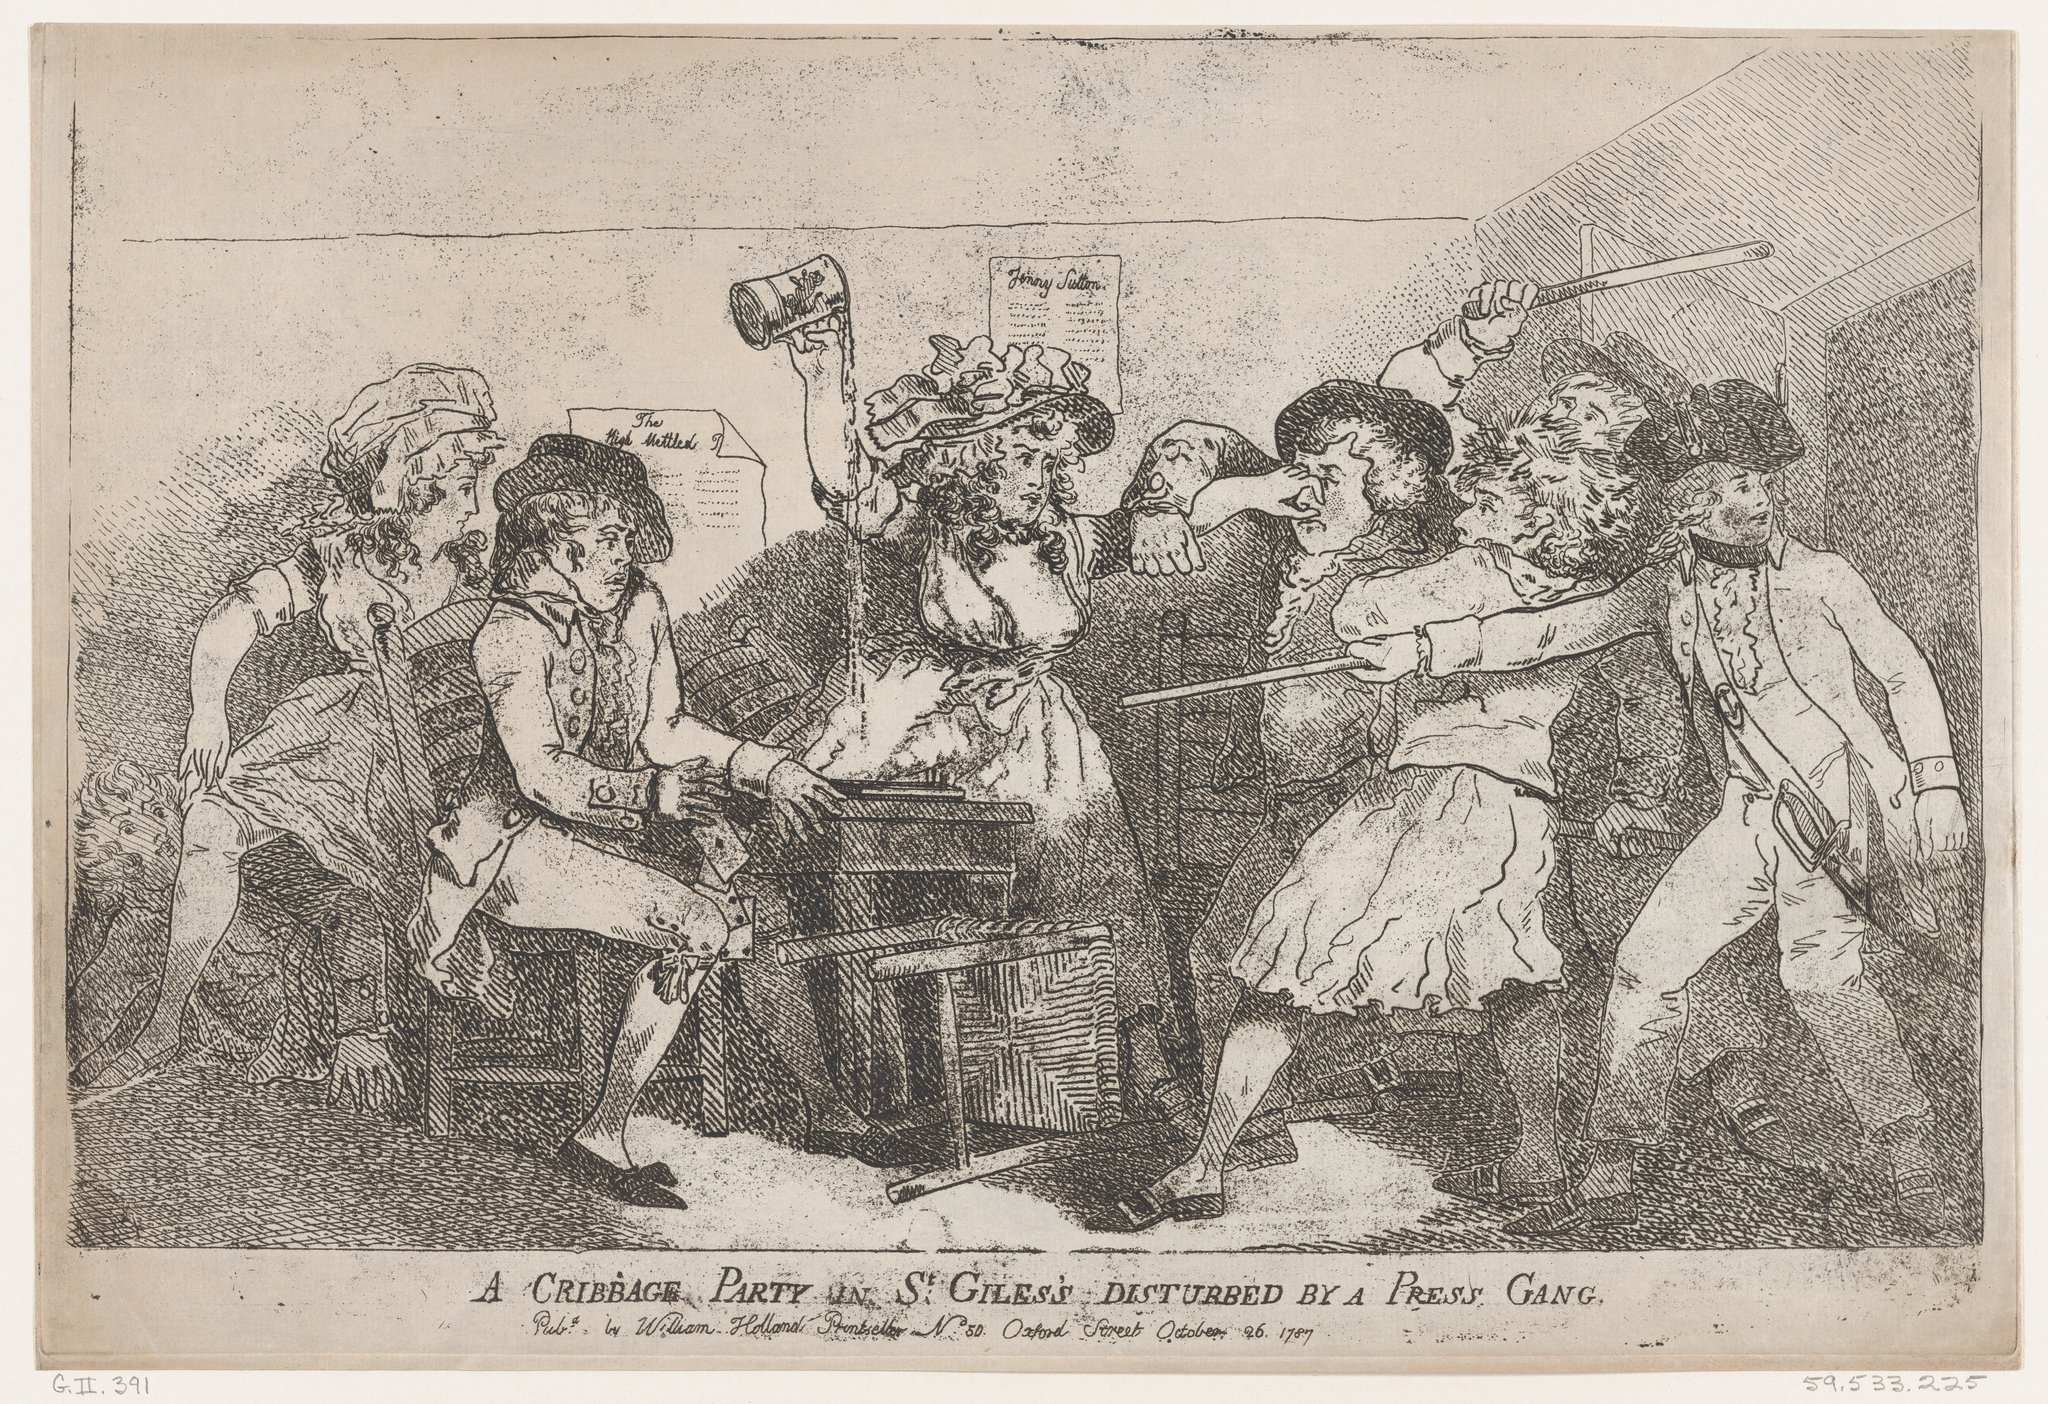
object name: print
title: A Cribbage Party in St. Giles's Disturbed By A Press Gang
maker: thomas rowlandson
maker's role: artist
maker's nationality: british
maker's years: 1757-1827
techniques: etching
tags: men,women,party